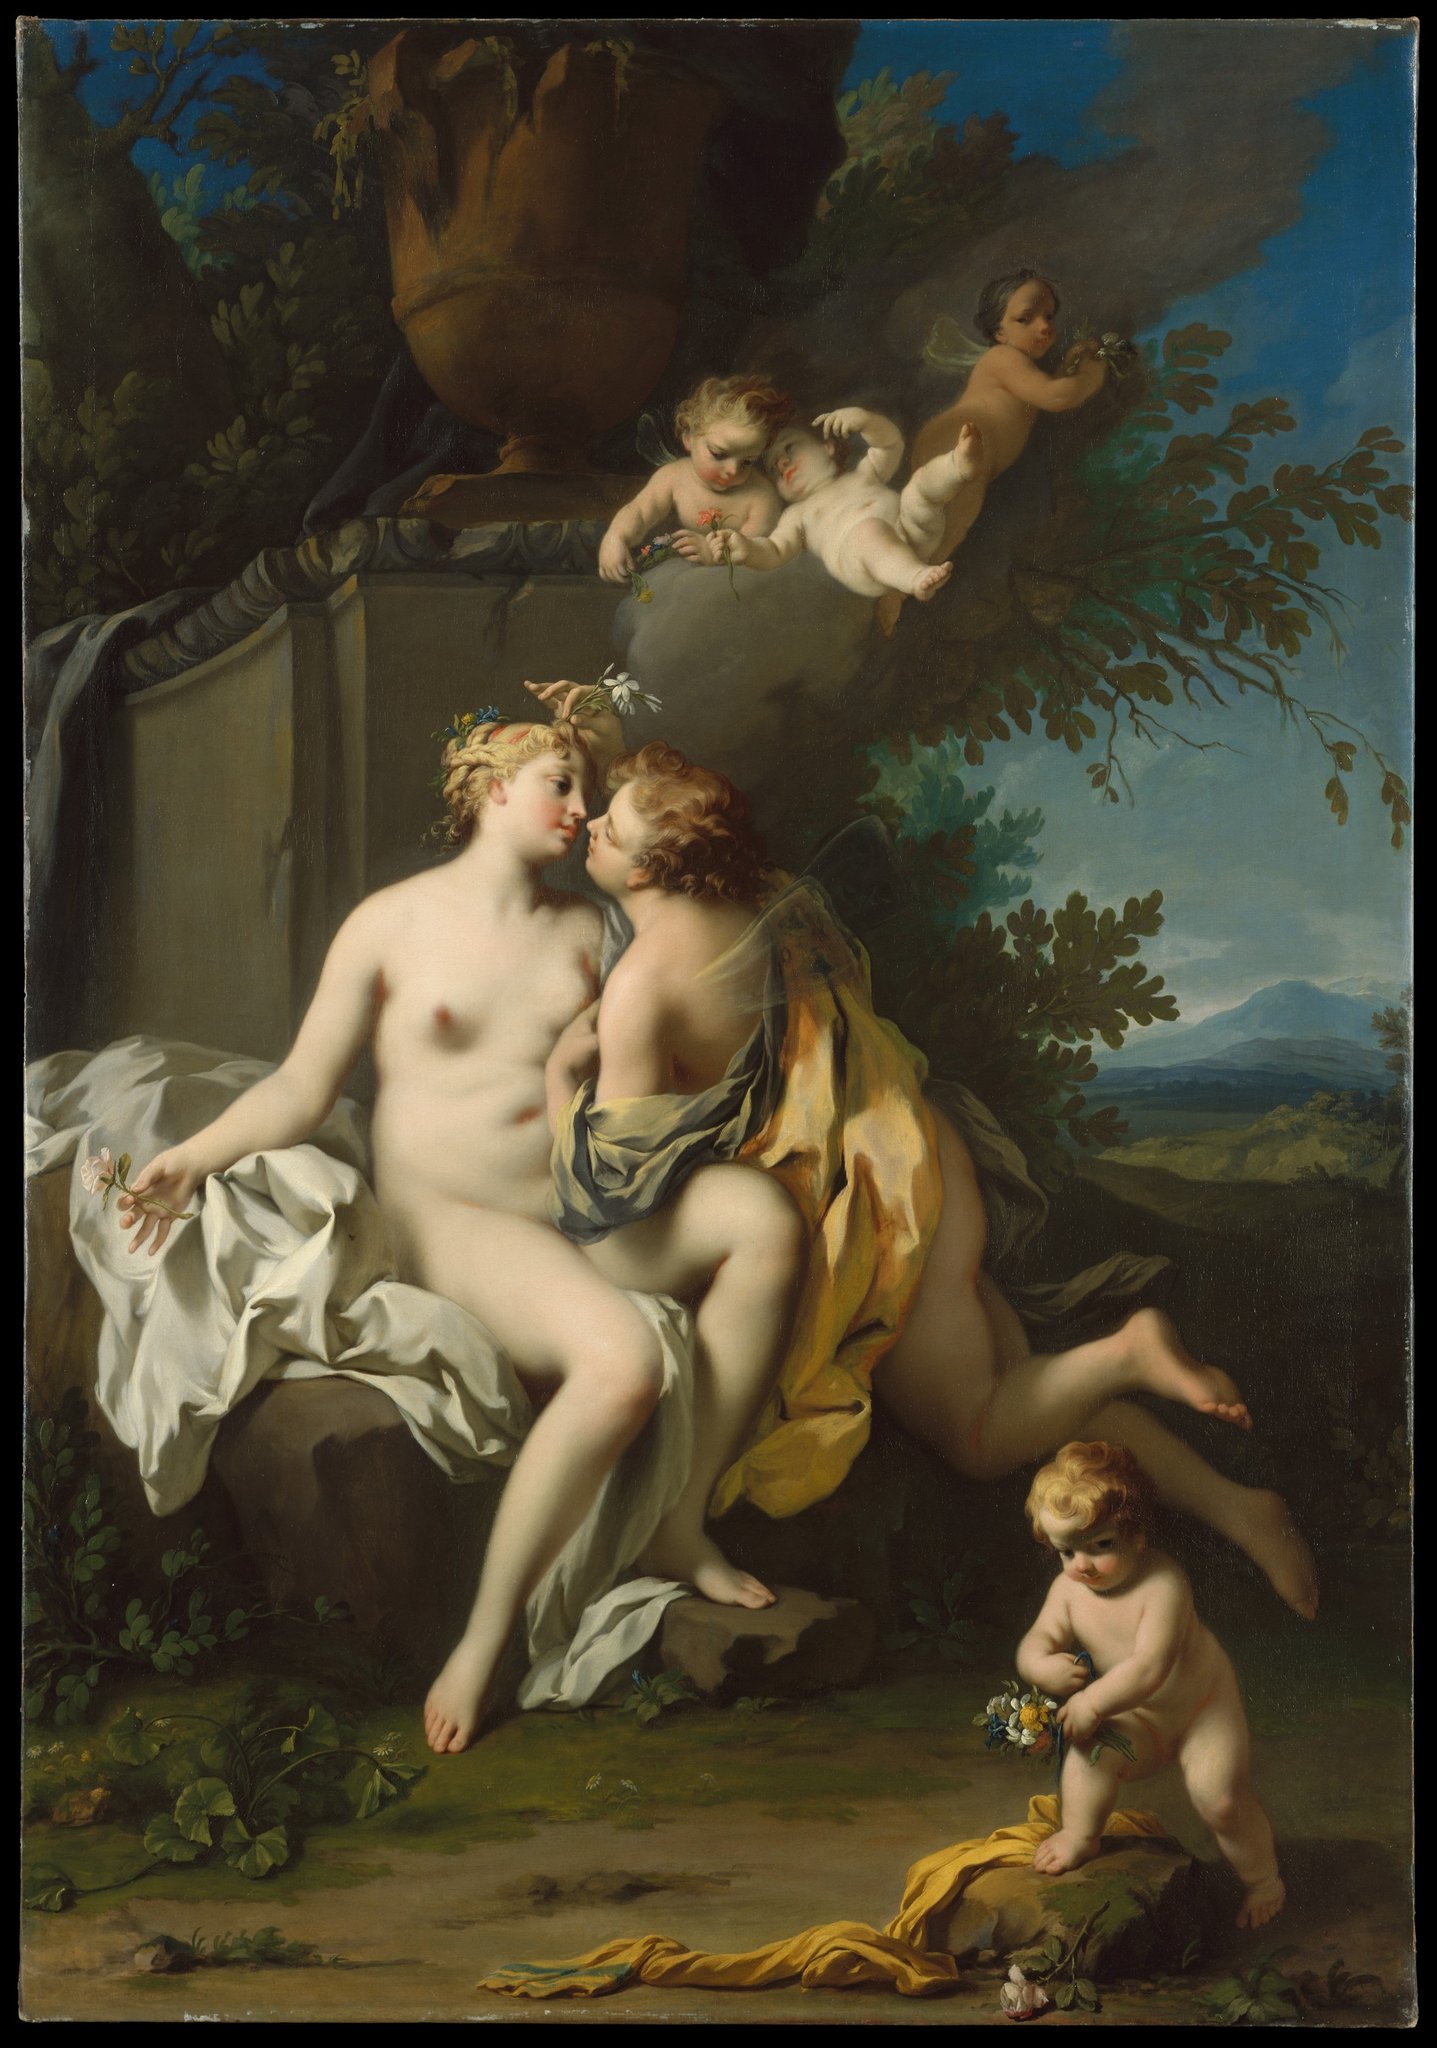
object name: painting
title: Flora and Zephyr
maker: jacopo amigoni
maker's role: artist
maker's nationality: italian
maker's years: 1682-1752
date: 1730-1739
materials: canvas, oil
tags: putti,flowers,landscapes,goddess